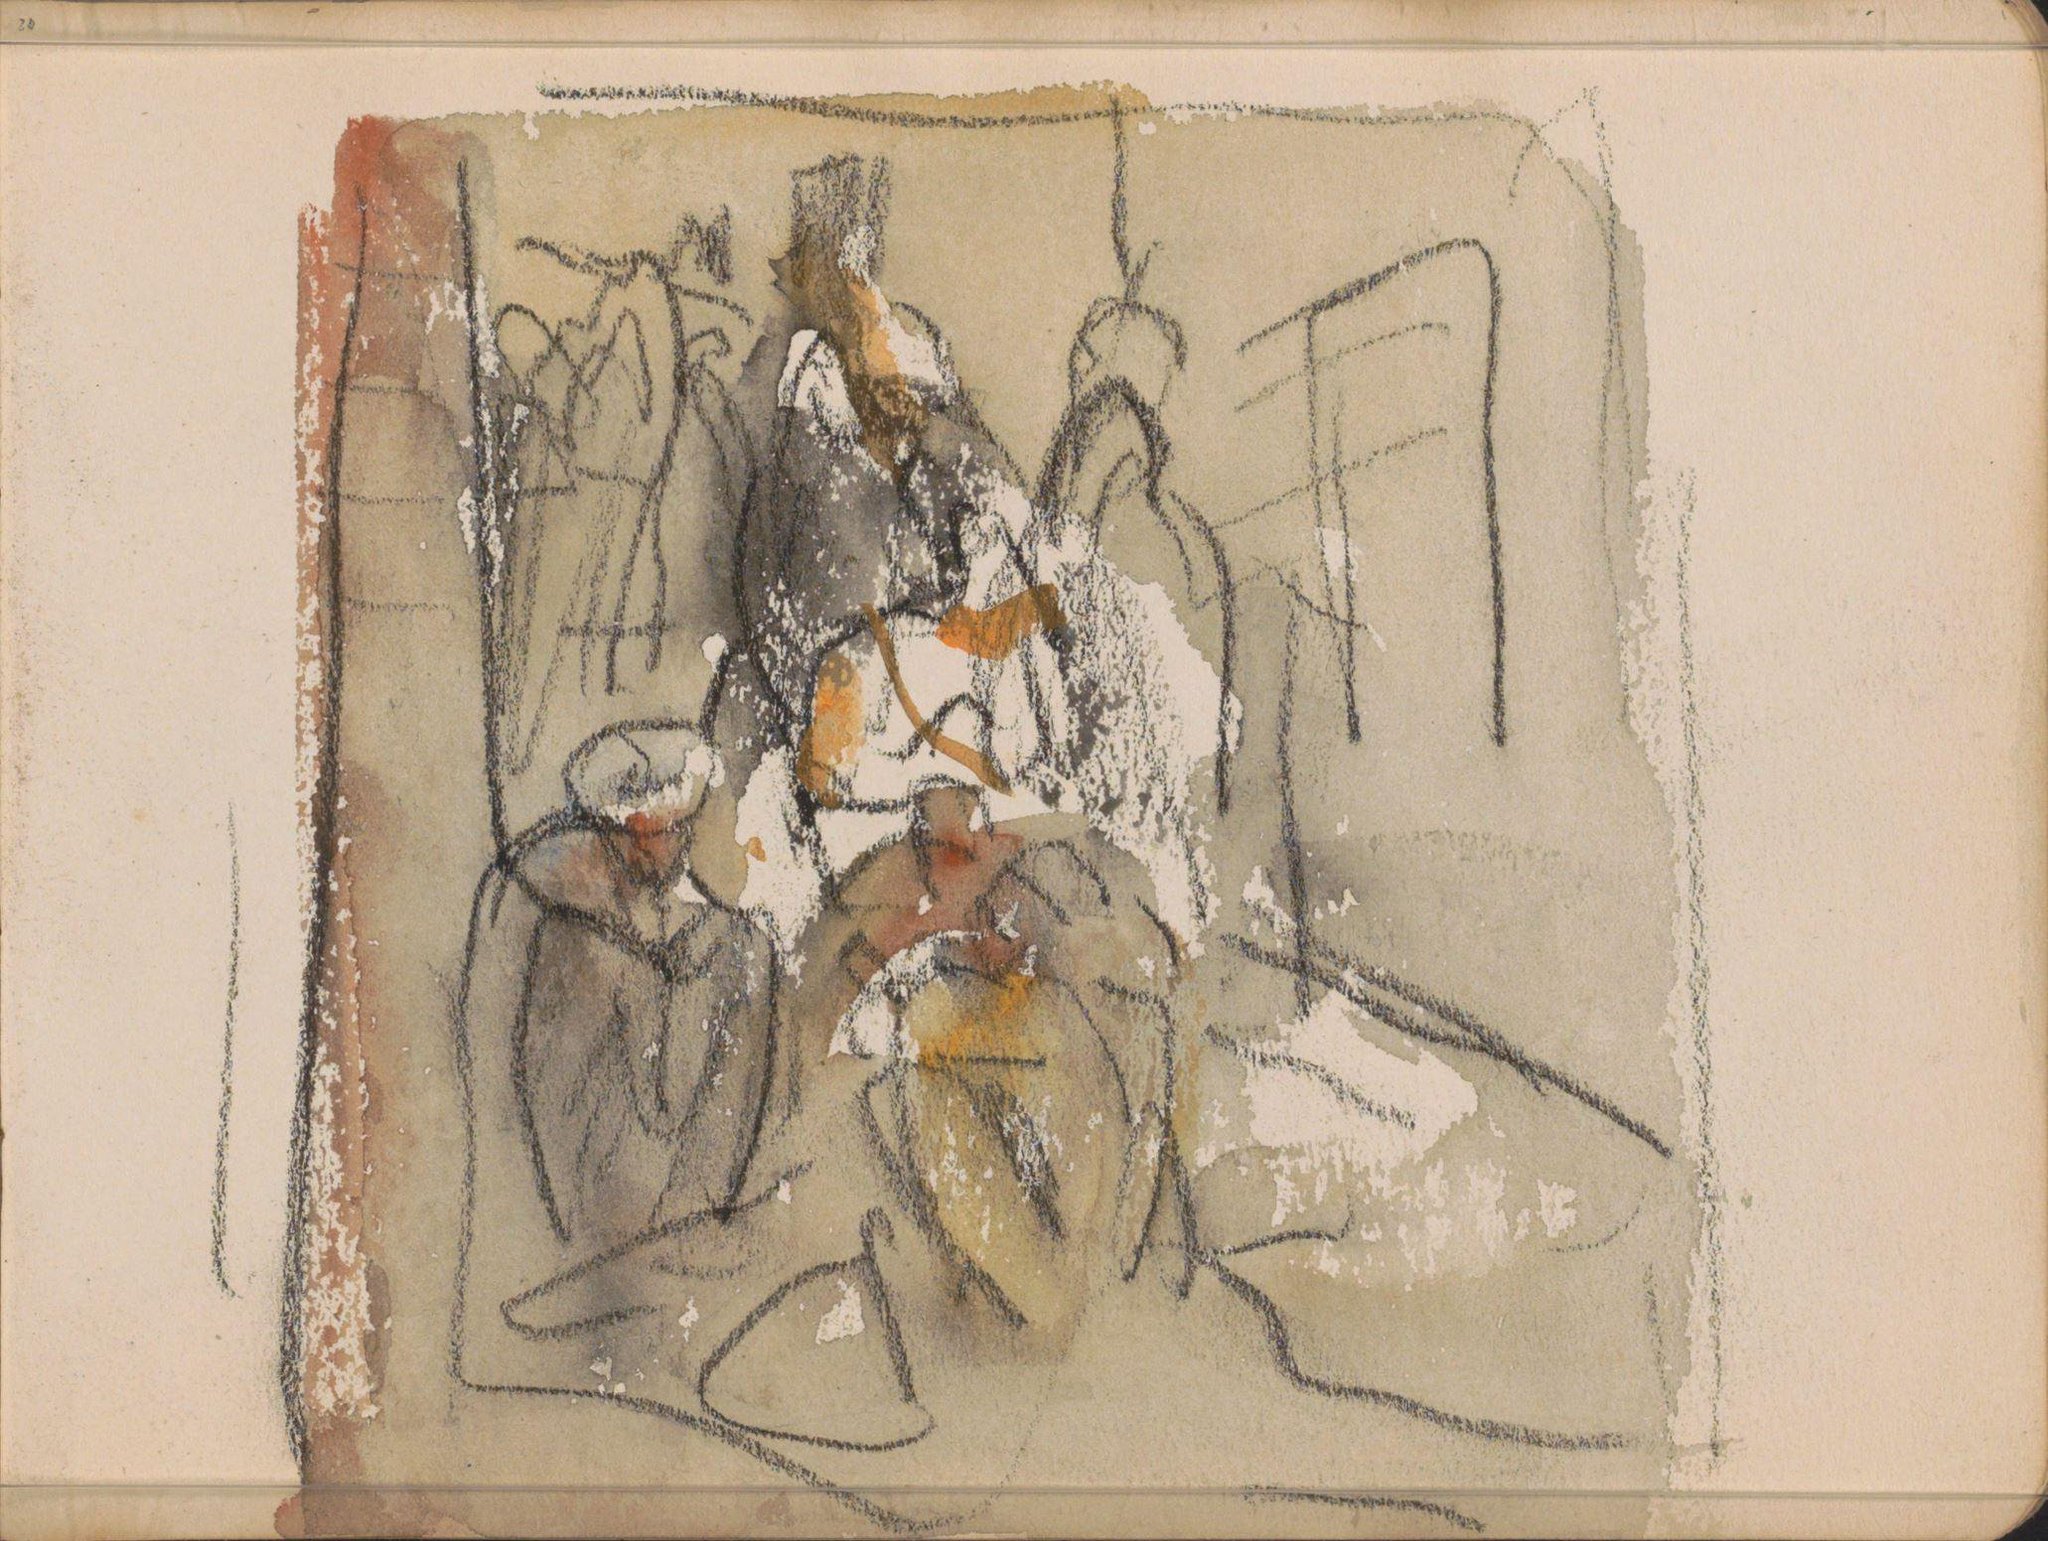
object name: sketchbook leaf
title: Straat met figuren in Luxor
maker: marius bauer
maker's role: draughtsman, print maker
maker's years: 1867-1932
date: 1919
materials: chalk, paper, watercolor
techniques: brush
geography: luxor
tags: africans, street (+ city(-scape) with figures, staffage)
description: Pagina 20 uit een schetsboek met 28 bladen.